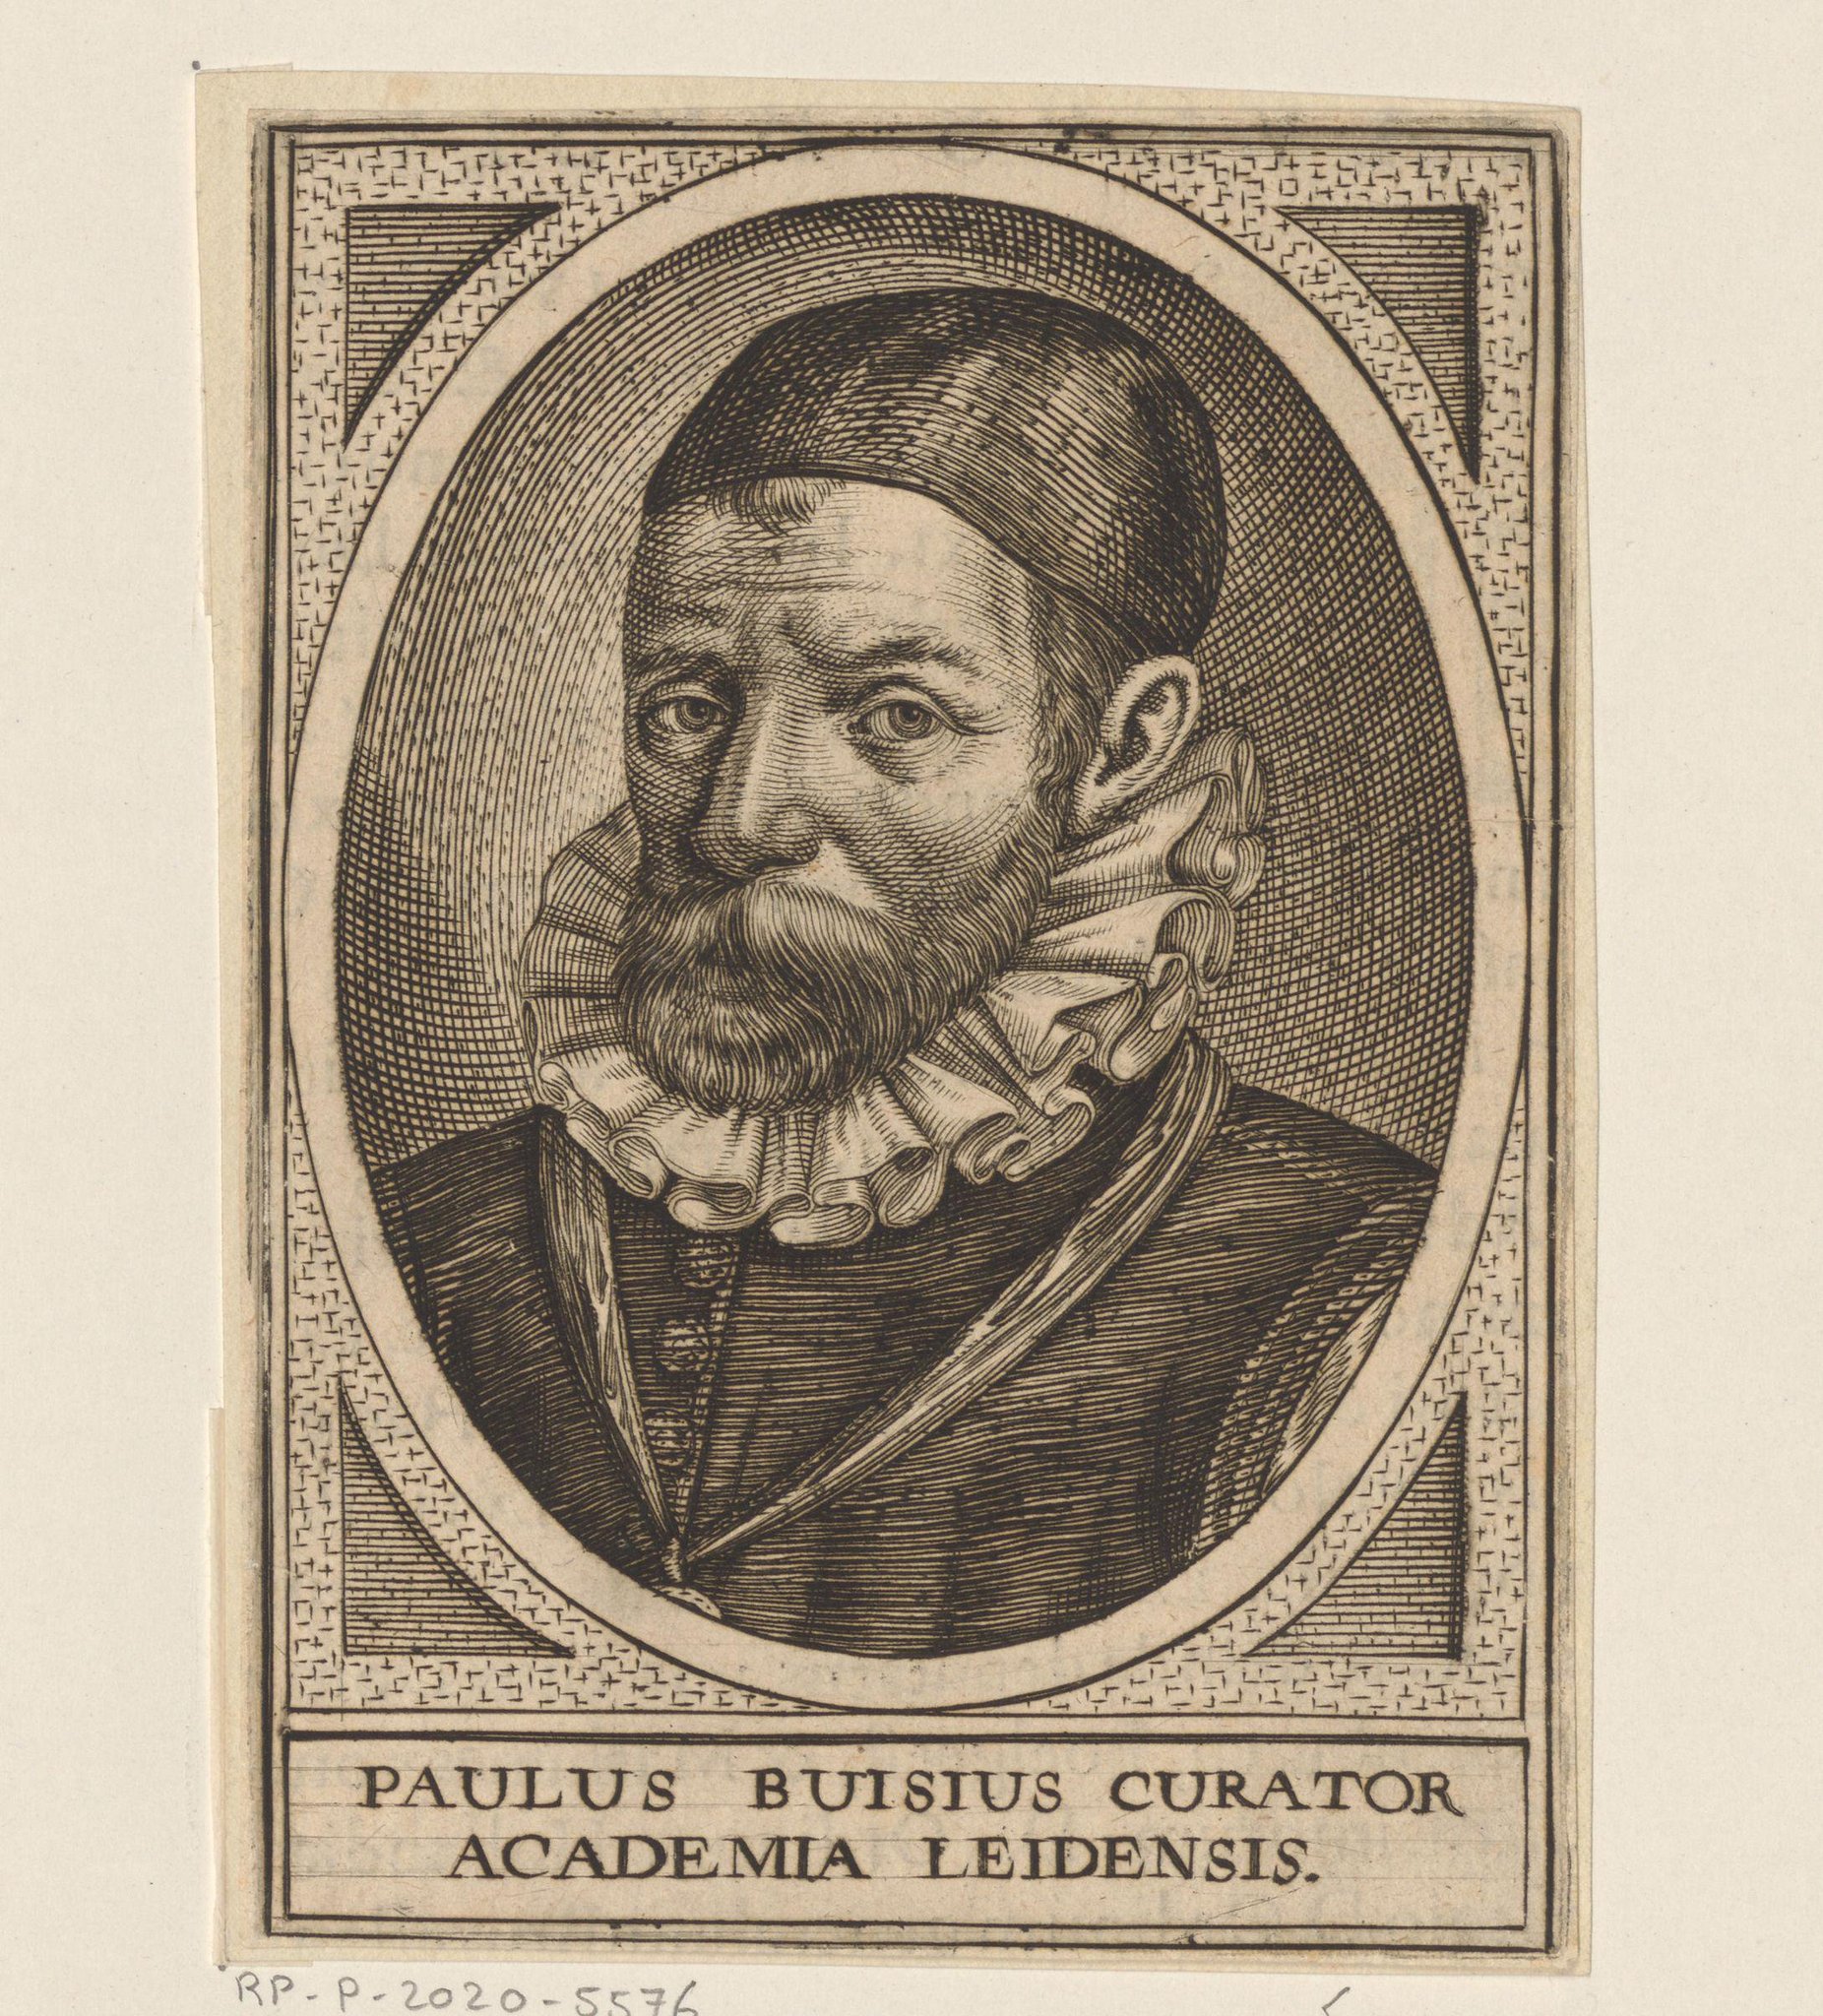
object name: book illustration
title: Portret van Paulus Buys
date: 1614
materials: paper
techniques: engraving, letterpress printing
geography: leiden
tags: university organization, historical persons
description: Prent uit: Illustrium Hollandiae & Westfrisiae ordinum alma academia Leidensis. Leiden: Jacob Marcus en Joost van Colster, 1614.